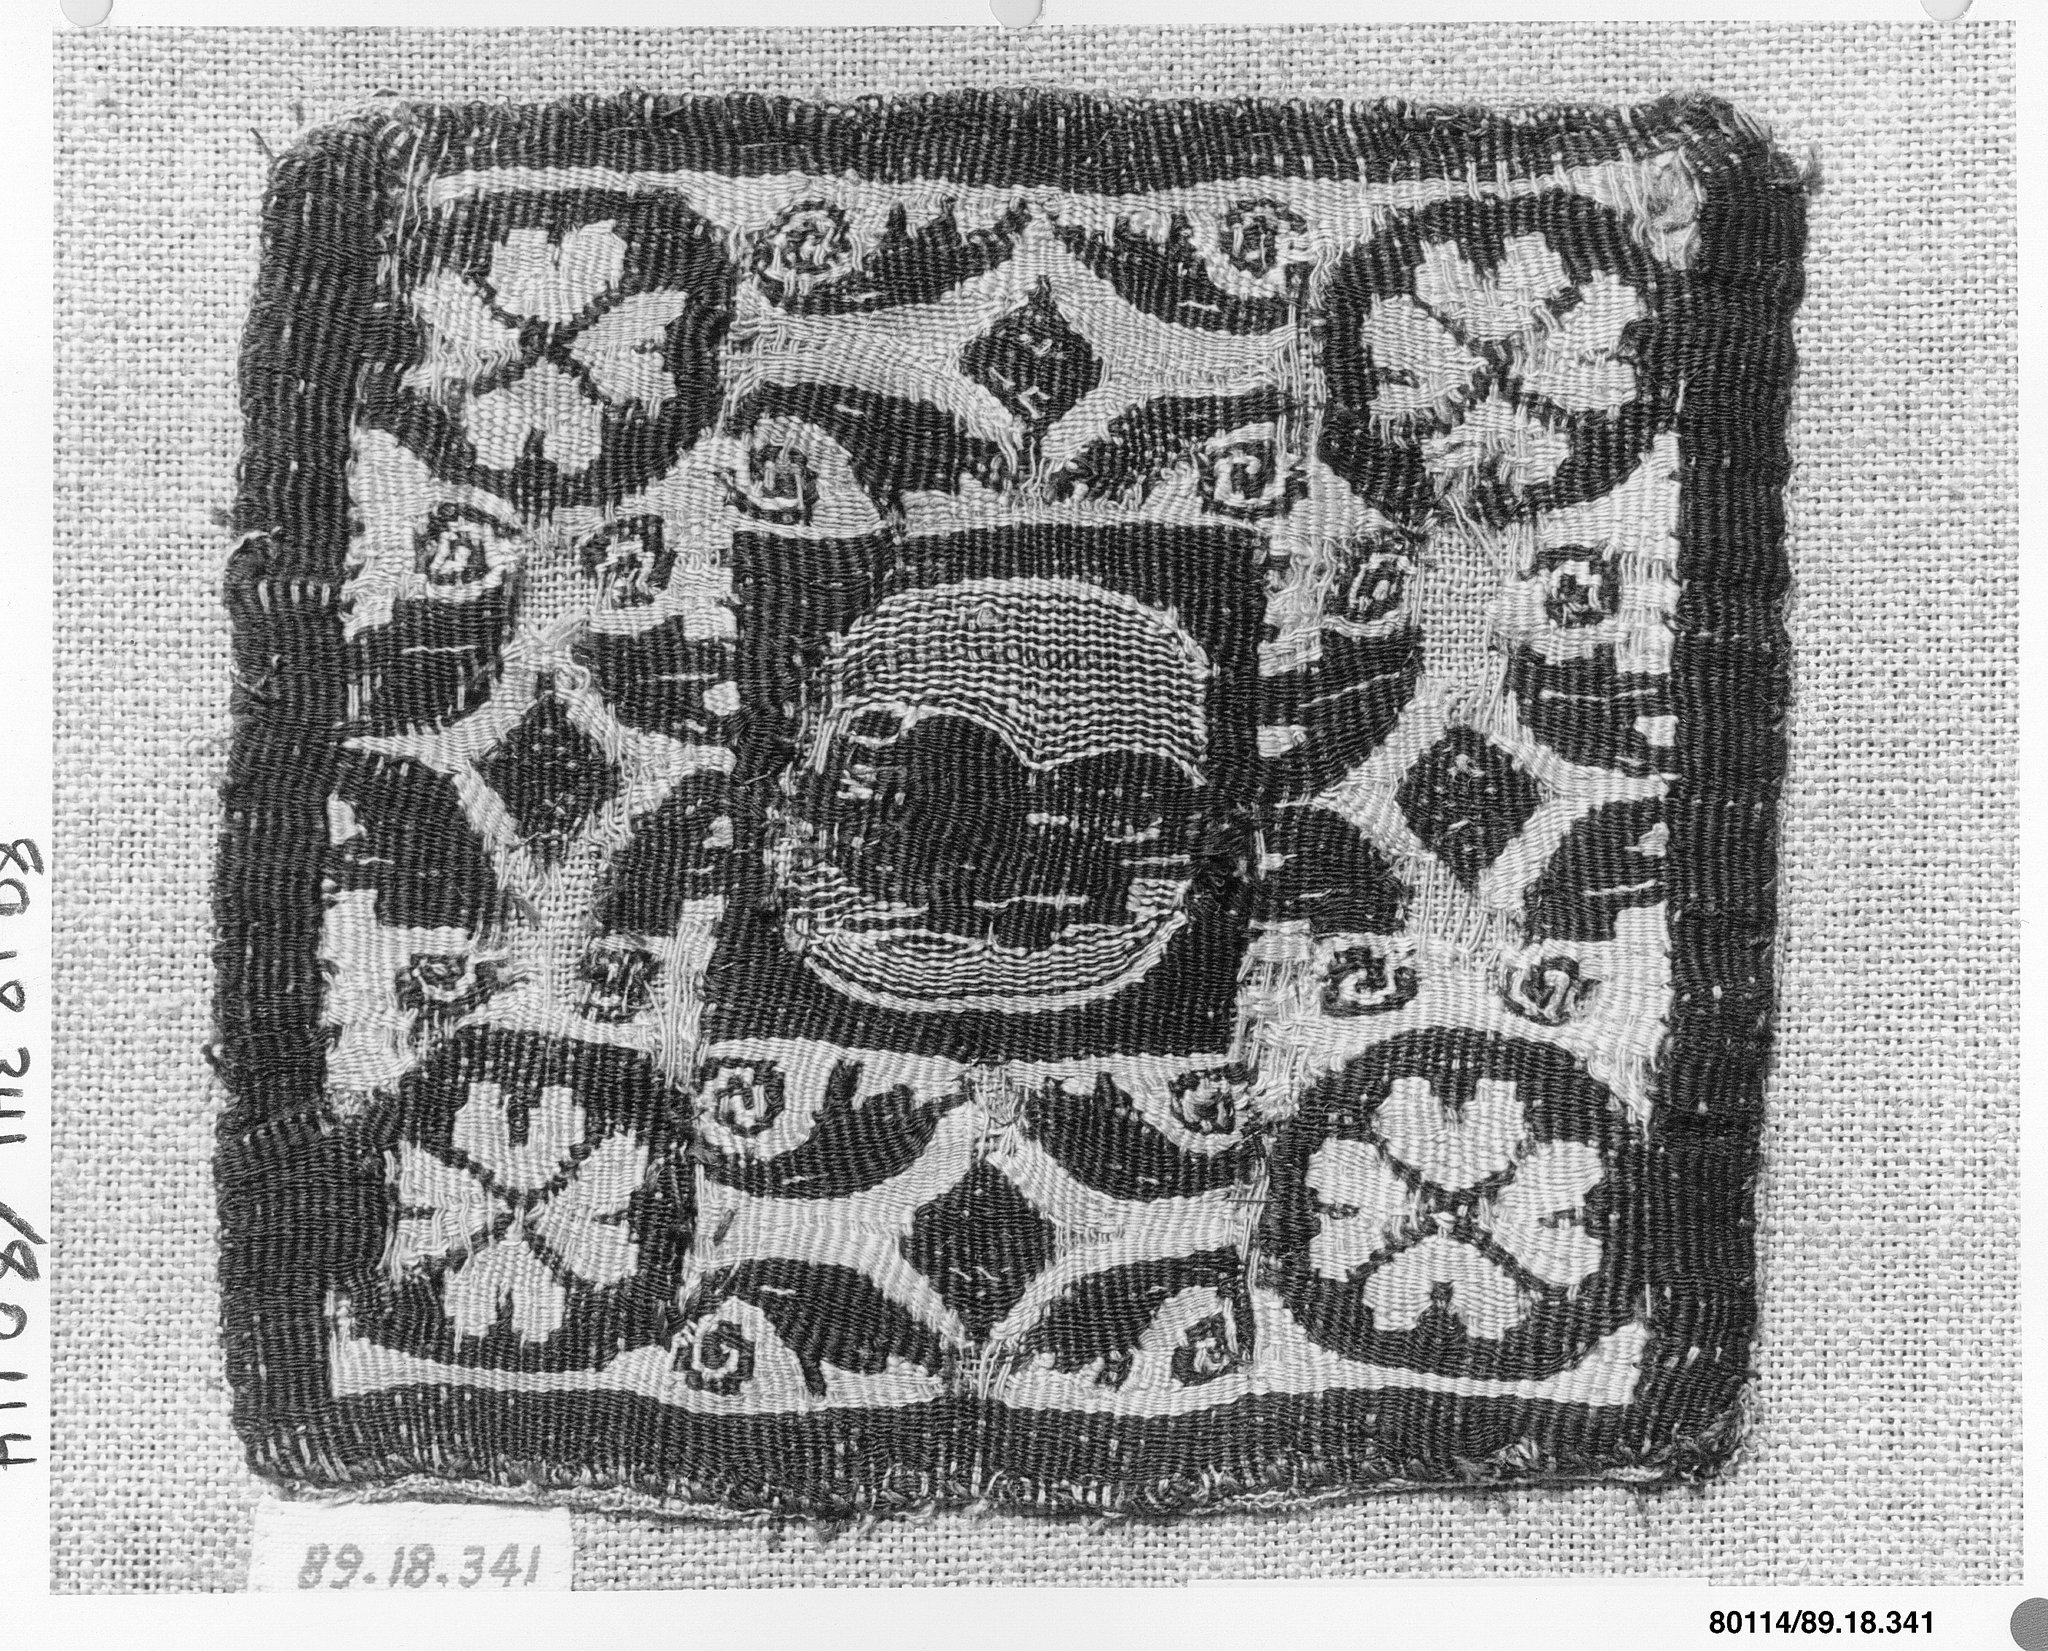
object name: textile fragment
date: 301-400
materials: linen, wool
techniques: weave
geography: egypt